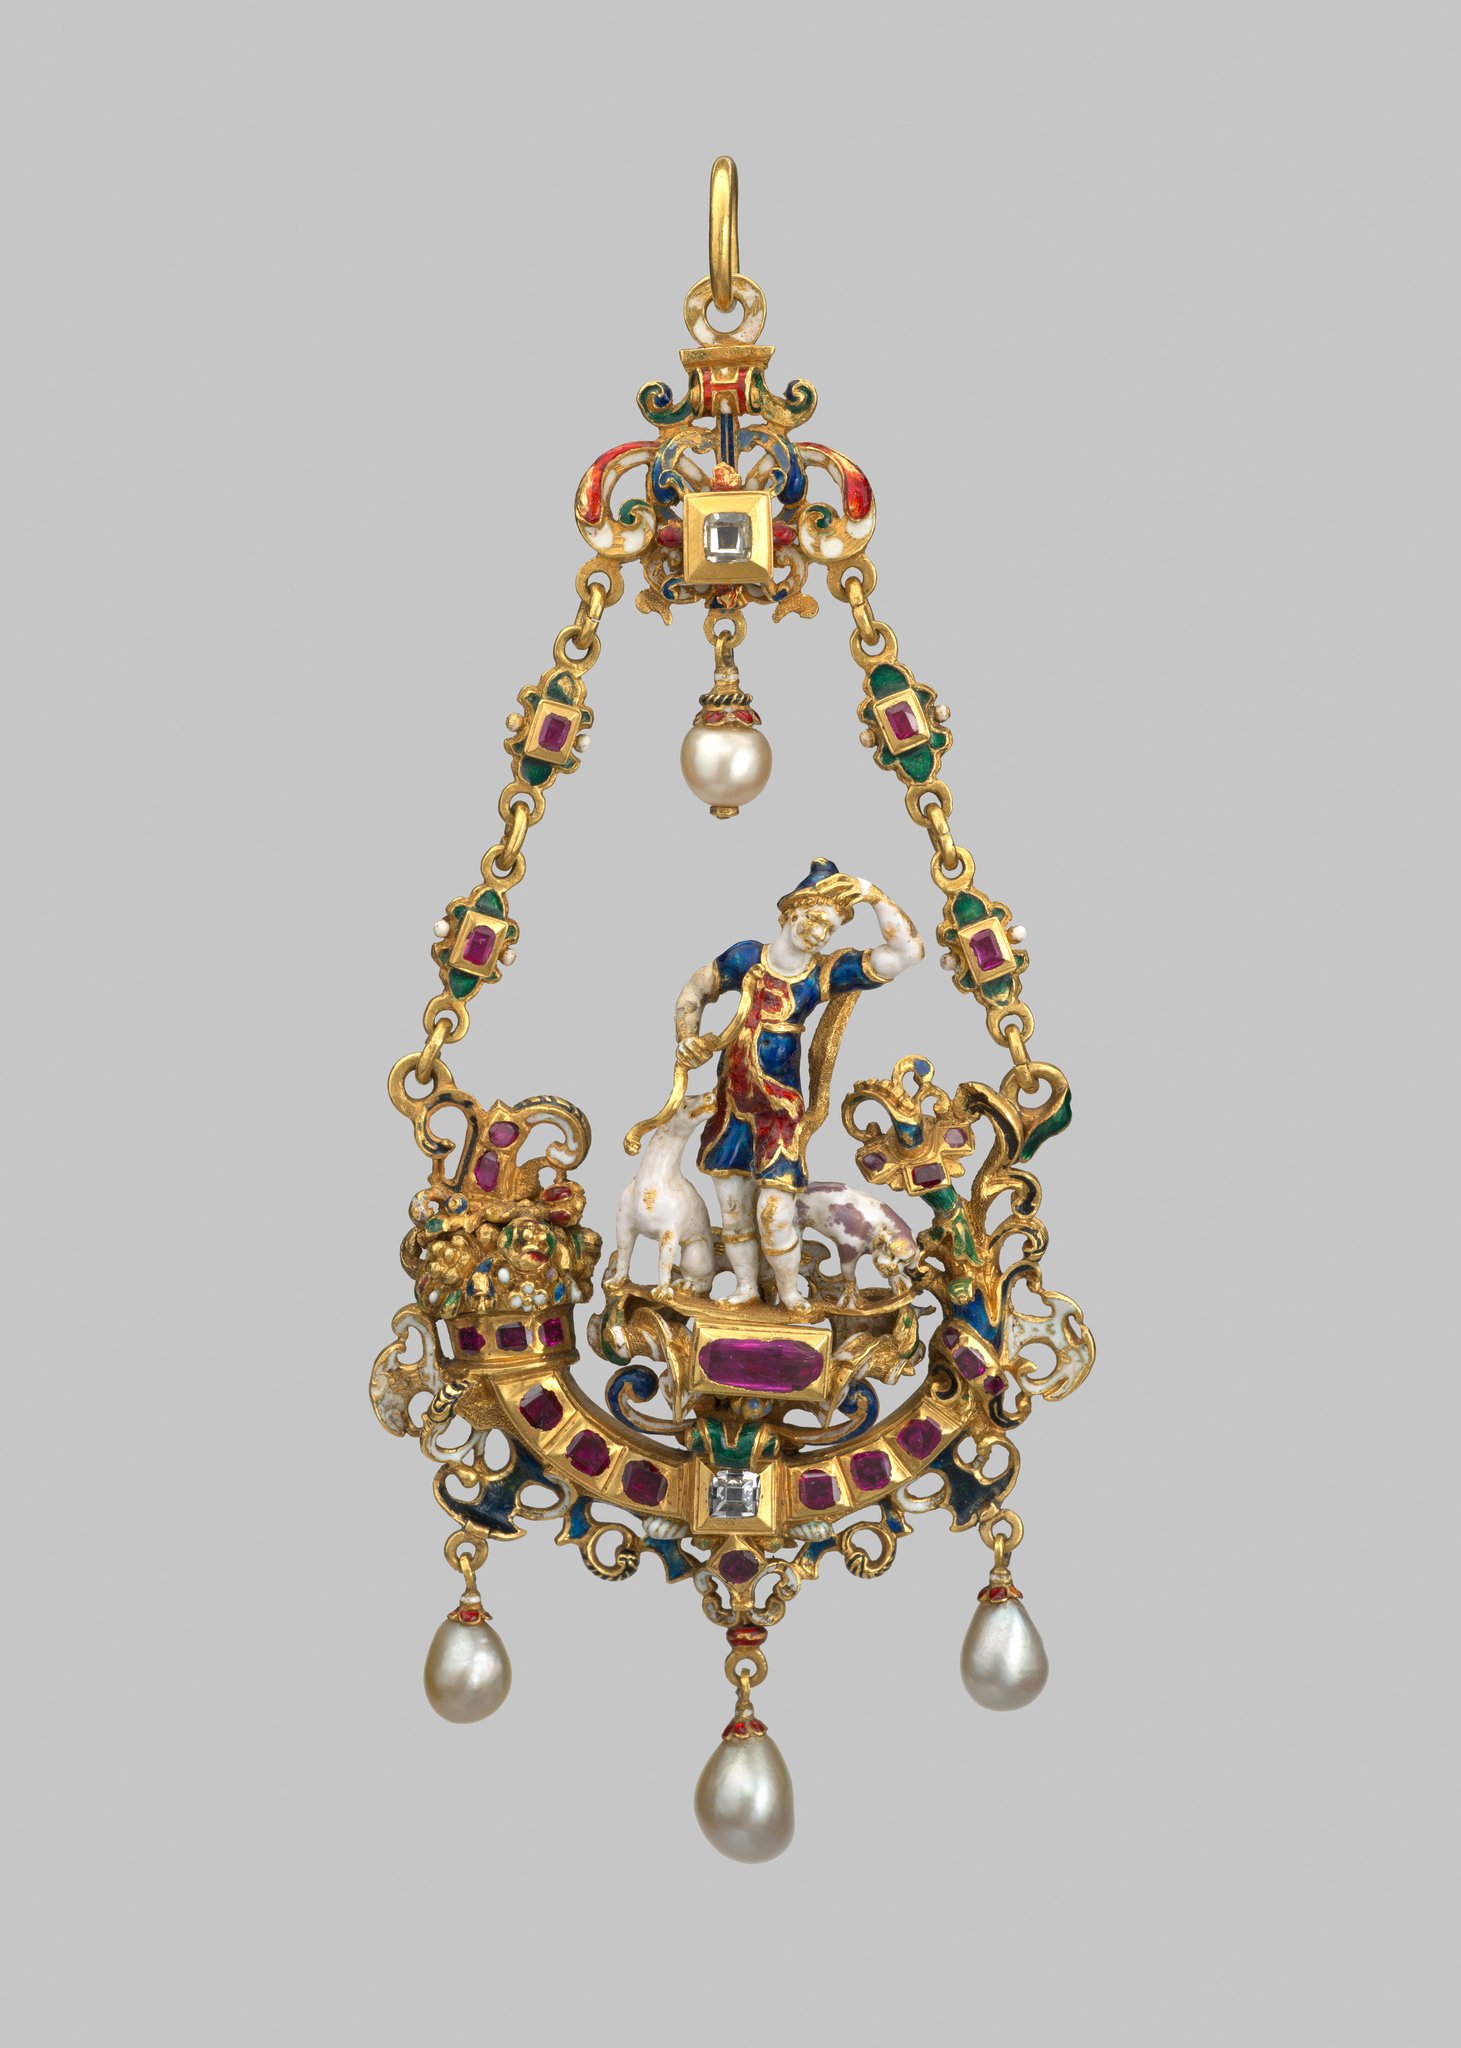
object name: pendant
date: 1600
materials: diamond, enamel, gold, pearl, gemstone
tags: animals,men